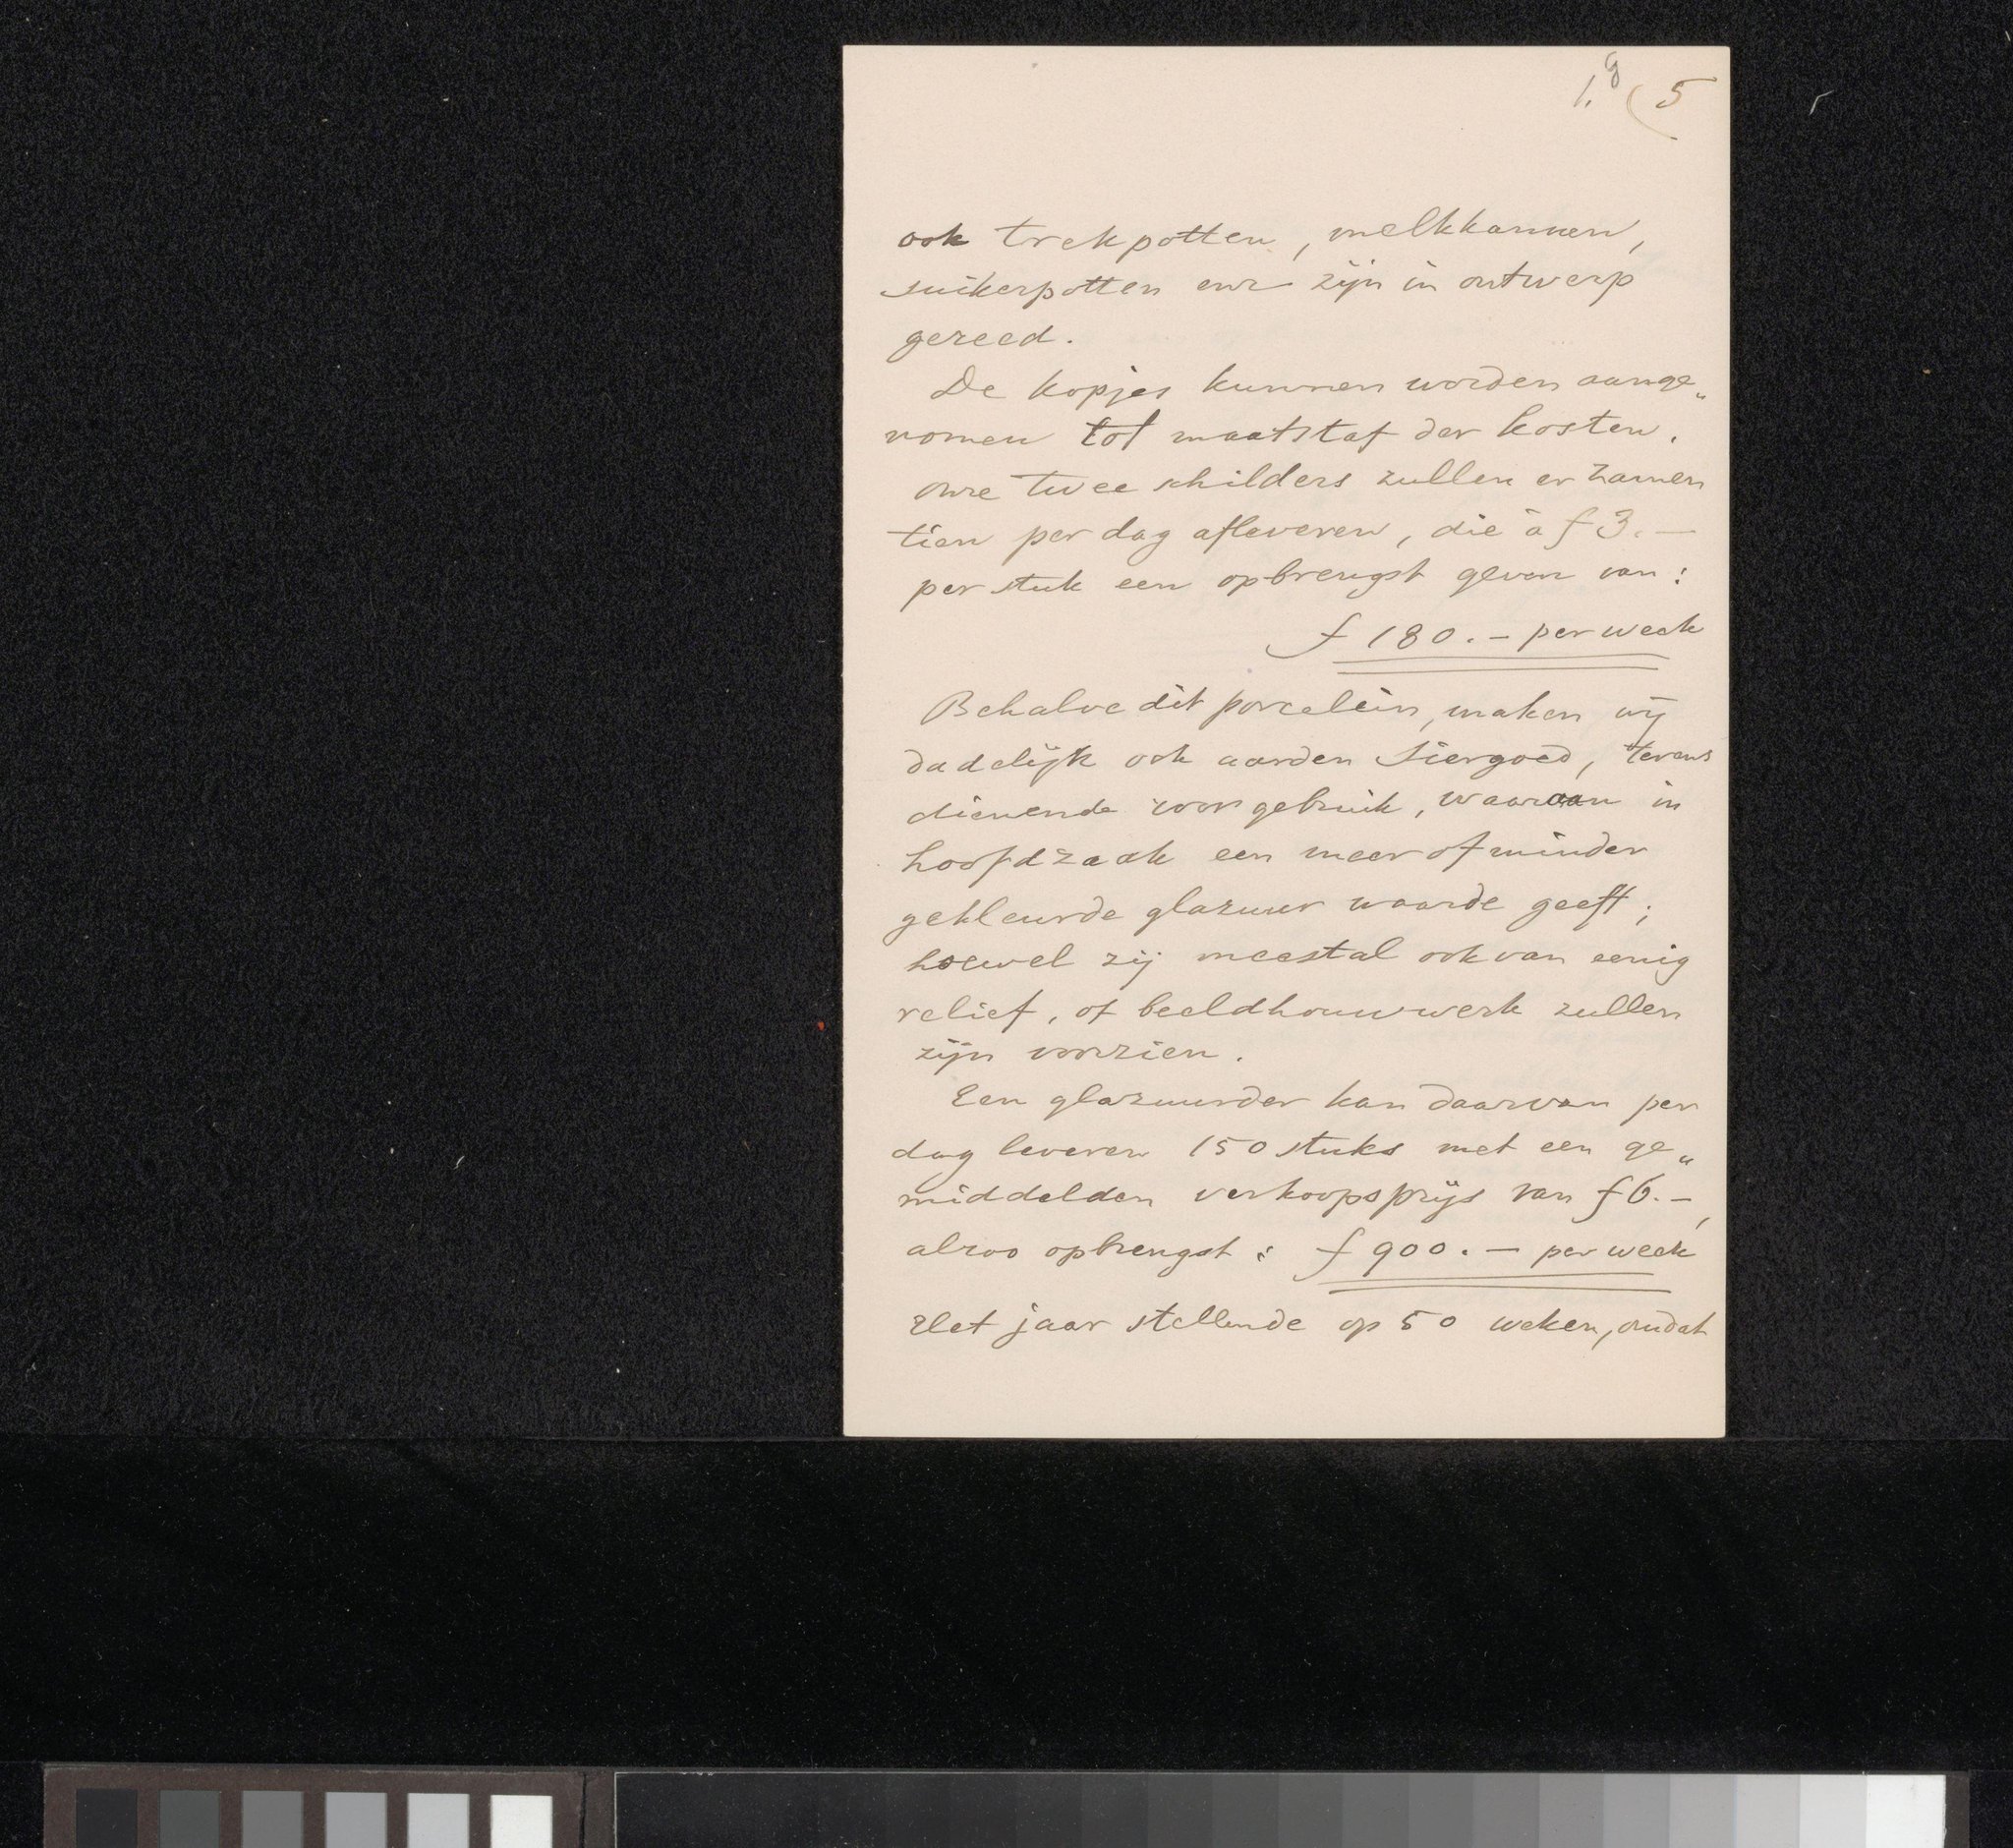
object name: letter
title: Brief aan Pieter Haverkorn van Rijsewijk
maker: theo colenbrander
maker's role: draughtsman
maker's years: 1841-1930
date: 1851-1915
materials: ink, paper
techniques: pen, writing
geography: arnhem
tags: pieter haverkorn van rijsewijk, applied arts, arts and crafts; industrial design, money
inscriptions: collector's mark: ‘RPK’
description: RP-D-COLENBRANDER.T.C.-1A en RP-D-COLENBRANDER-1B tot en met RP-D-COLENBRANDER-1H vormen een doorlopende brief. RP-D-COLENBRANDER-1I is verstuurd als bijlage bij deze brief.